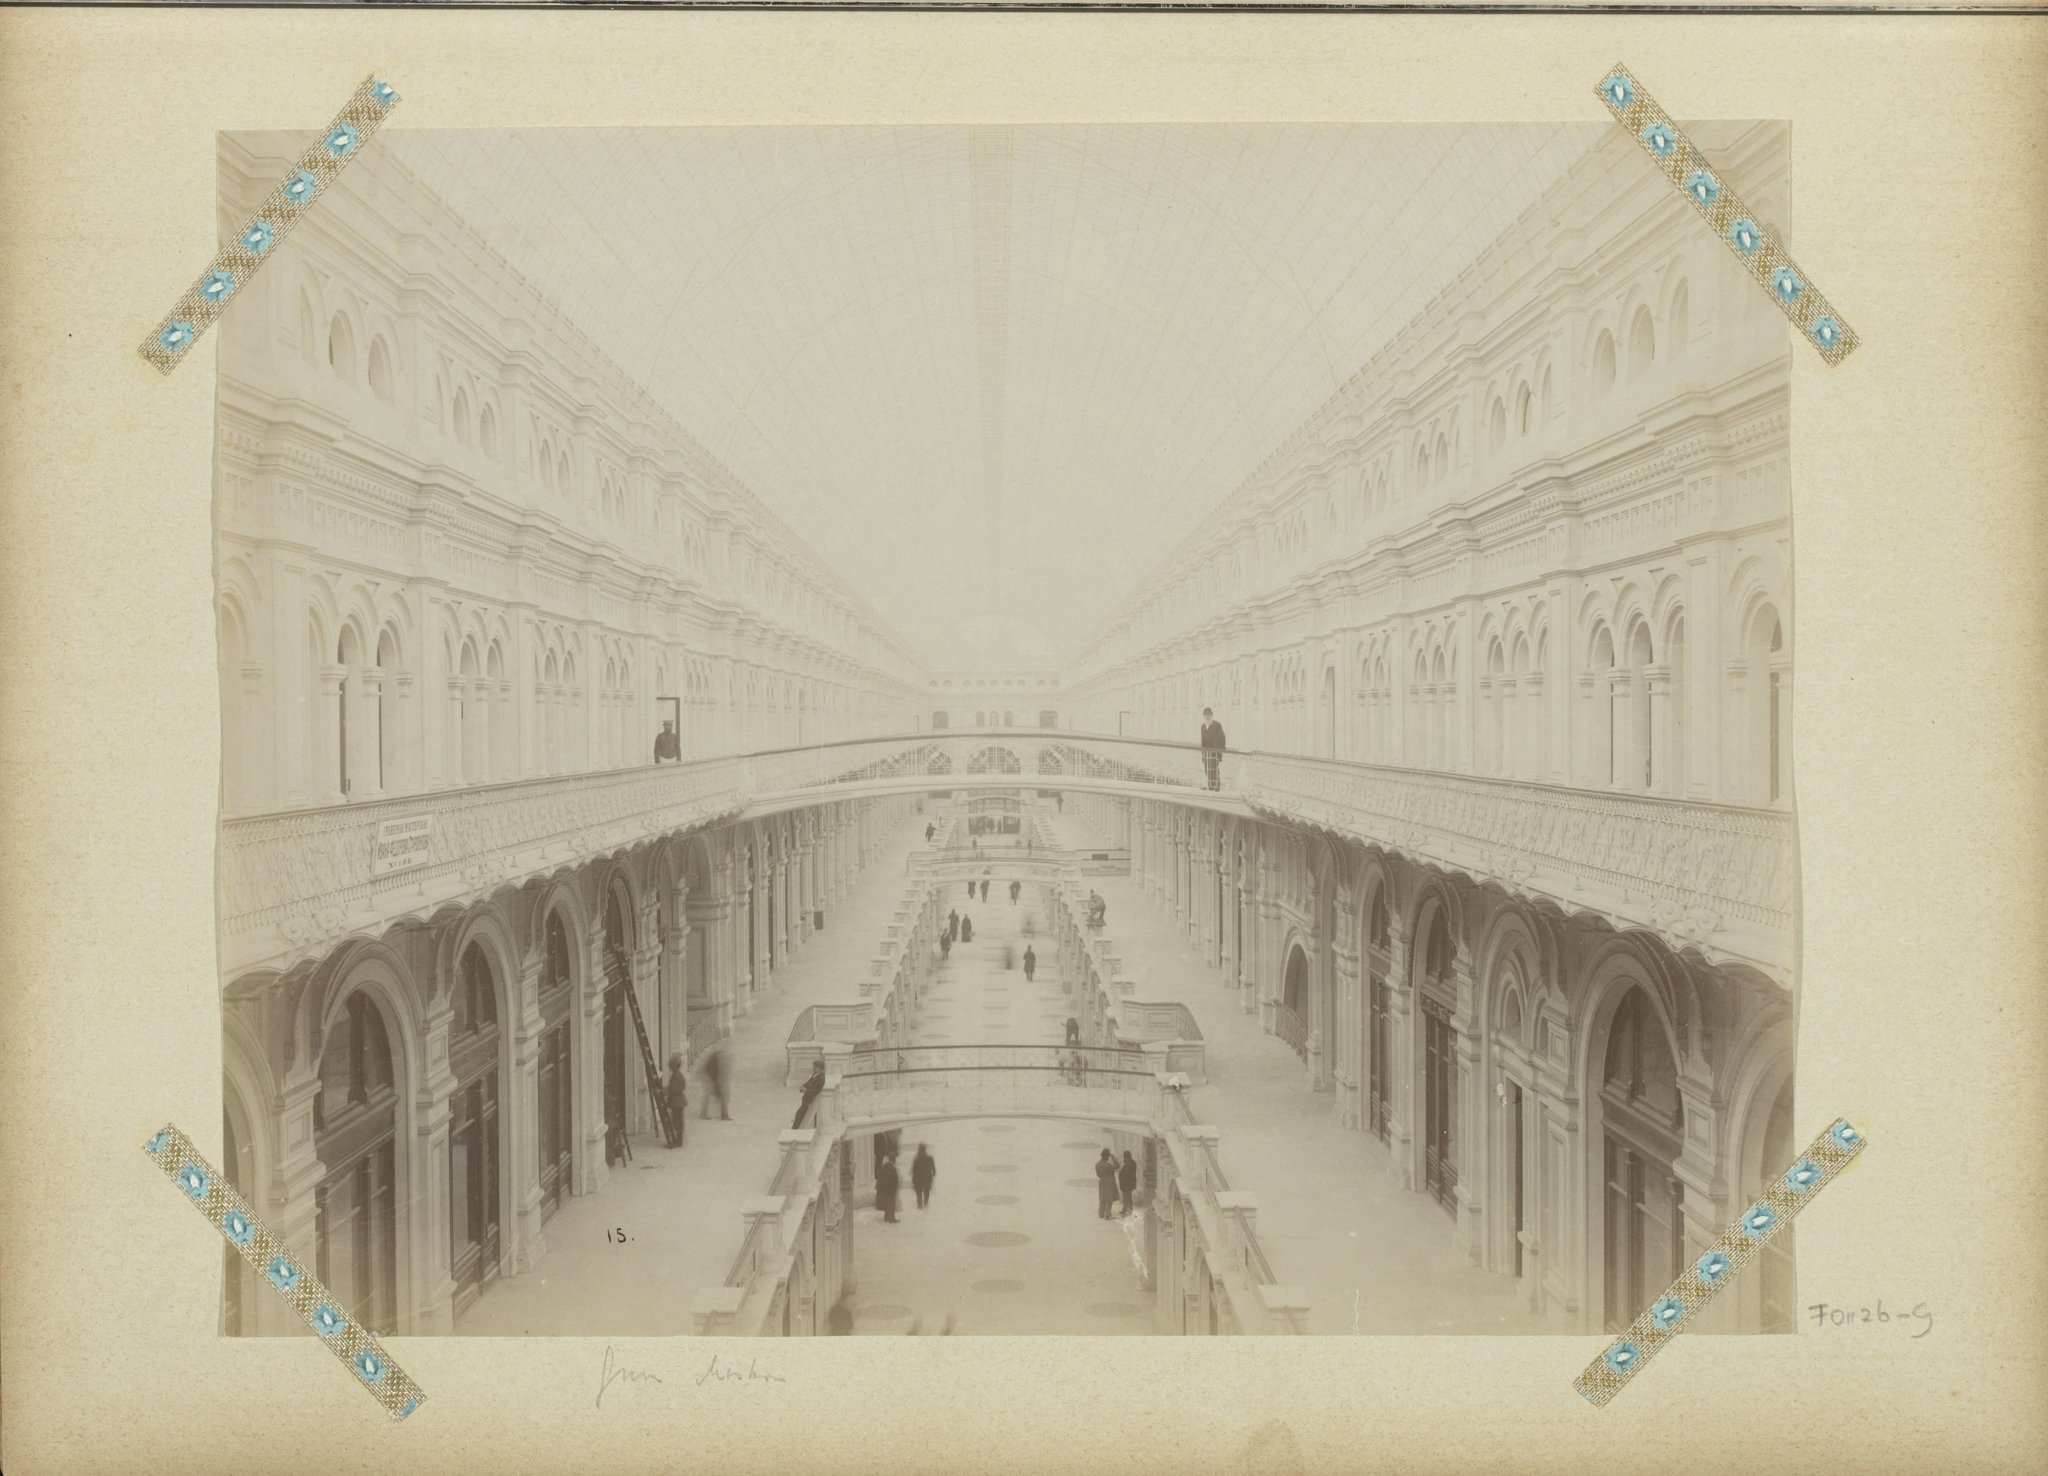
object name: photograph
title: Passage in warenhuis GOeM in Moskou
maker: Anonymous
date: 1888-1900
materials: photographic support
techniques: albumen print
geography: moscow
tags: department store, supermarket, passage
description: Onderdeel van Fotoalbum met opnames van bezienswaardigheden in Georgië, Sint-Petersburg en Moskou.